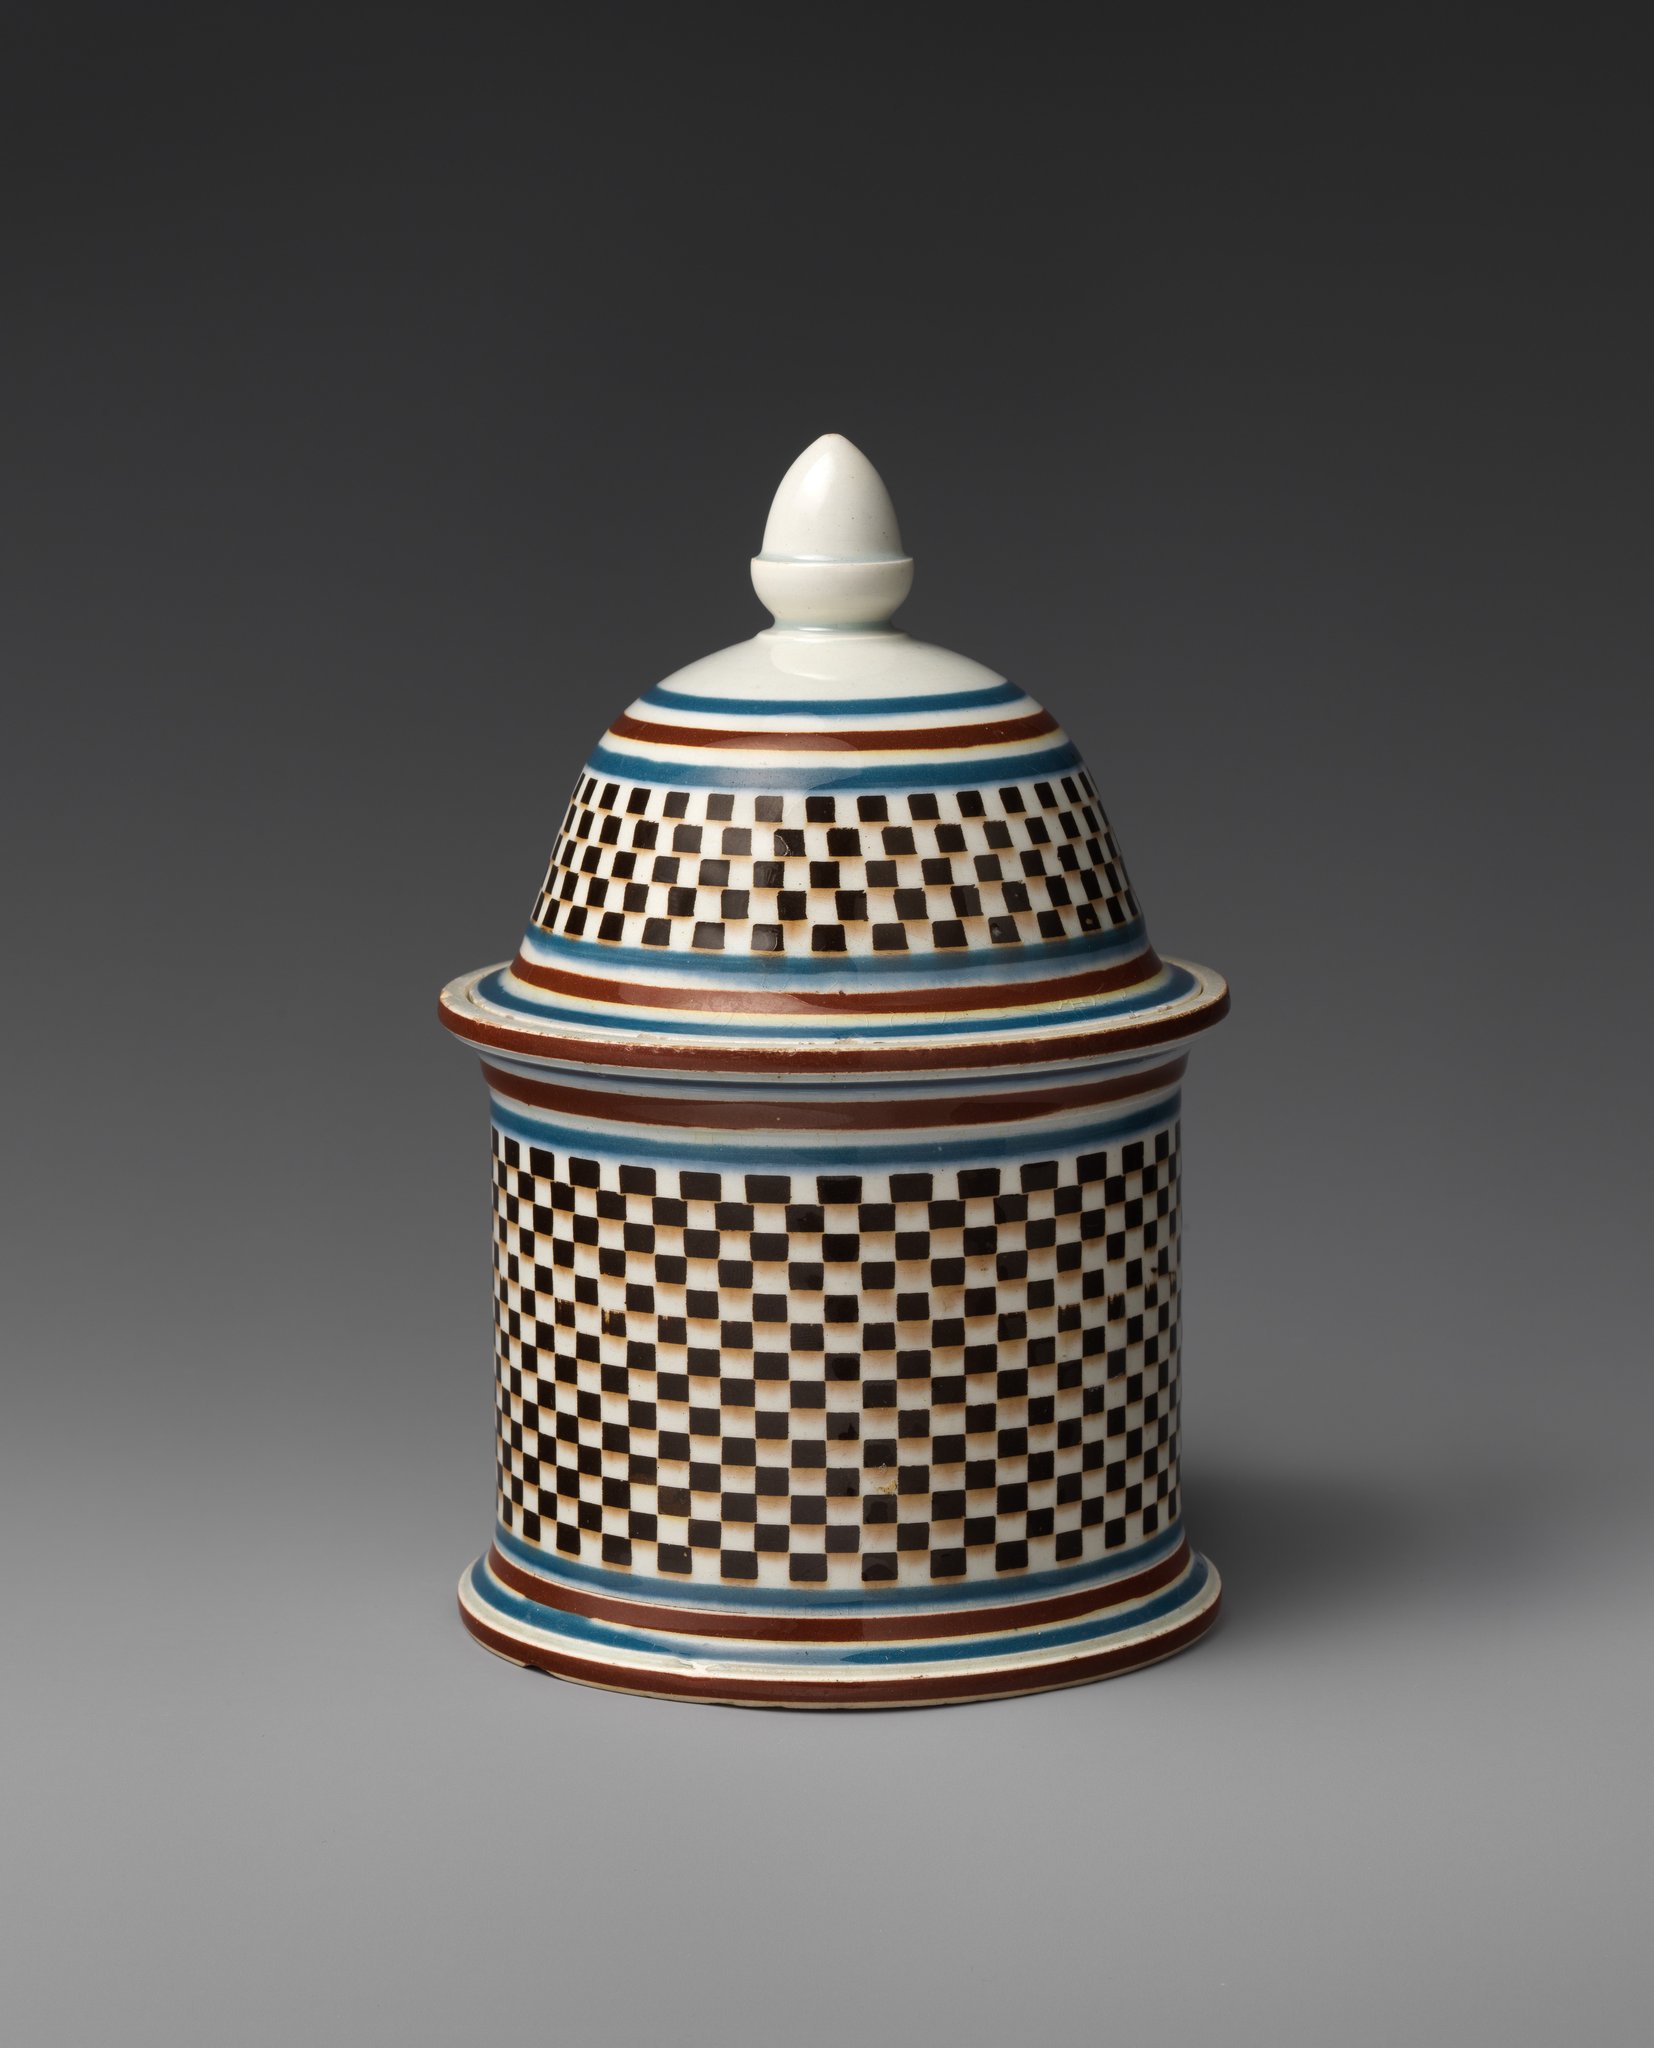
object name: humidor with cover and tamper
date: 1820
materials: pottery